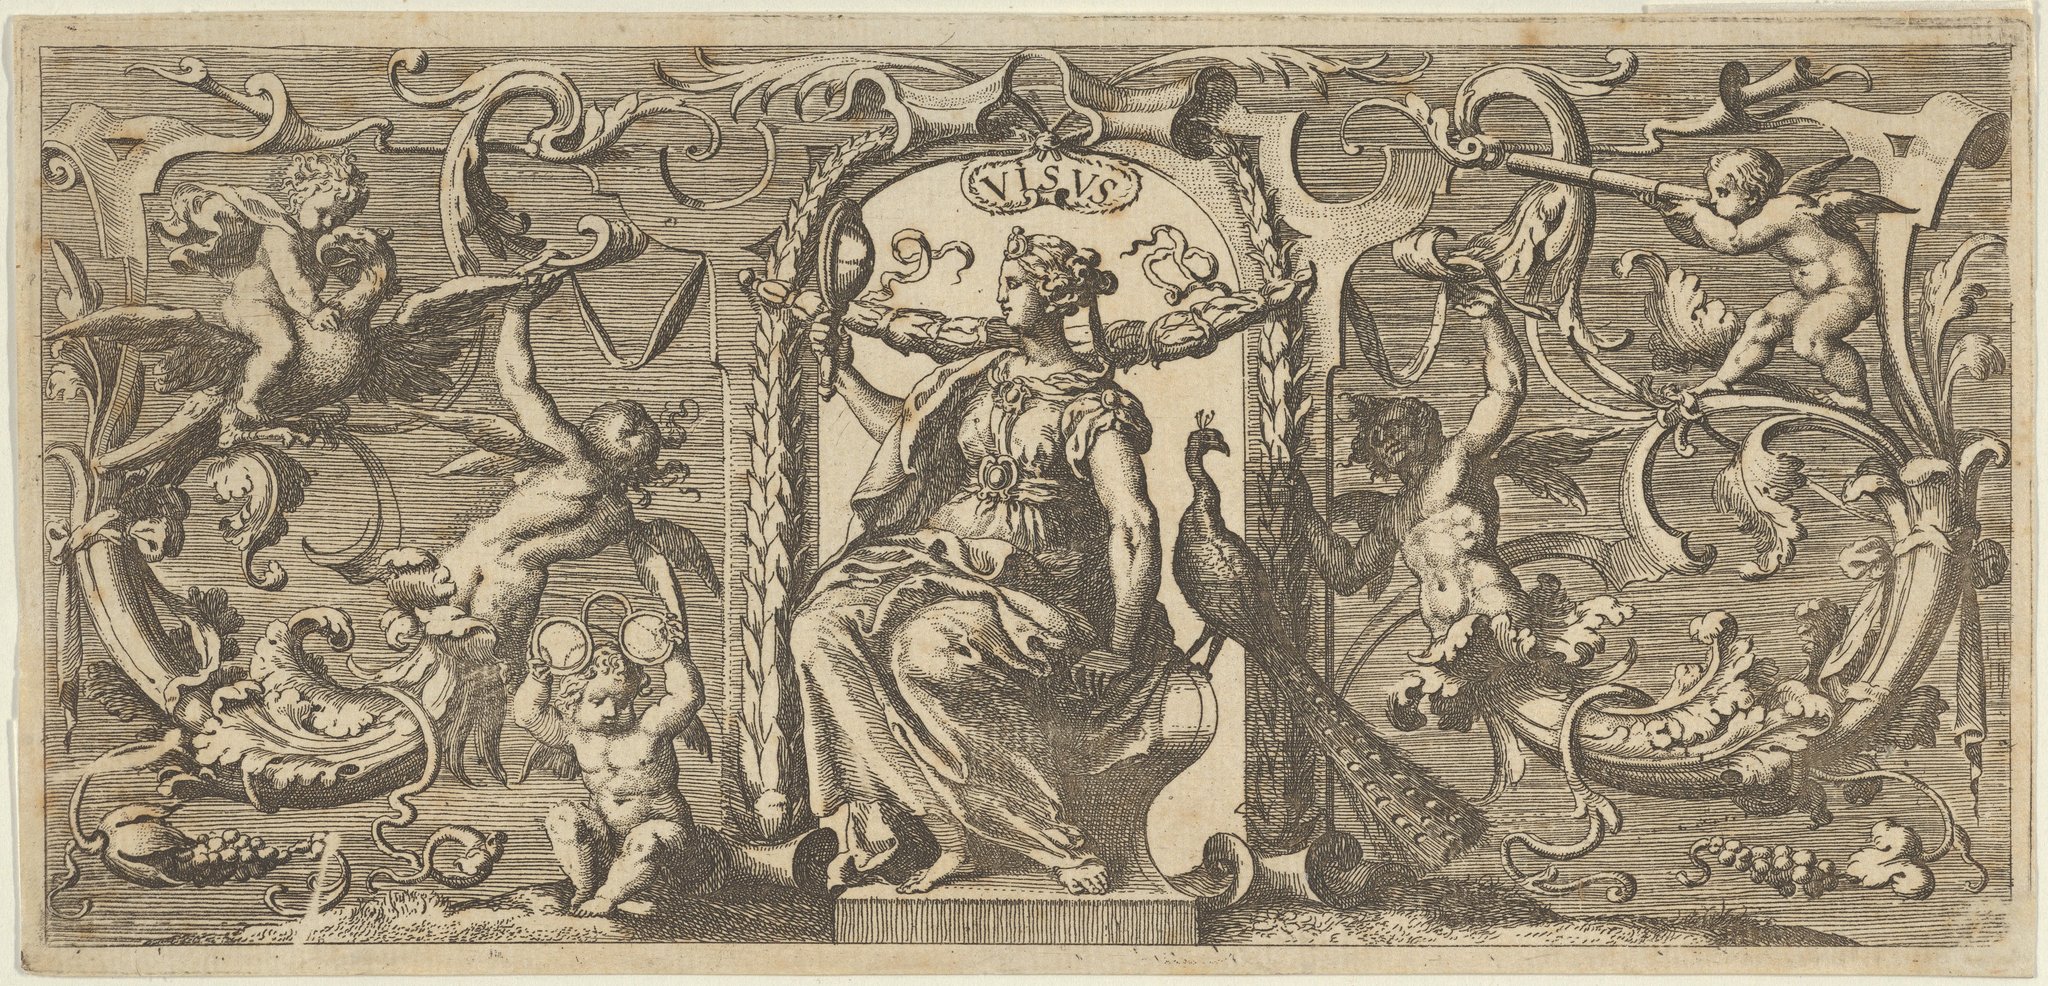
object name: print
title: Sight (Visus), from "Quinque Sensuum"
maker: franz cleyn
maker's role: artist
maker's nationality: german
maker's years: 1582-1658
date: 1655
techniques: engraving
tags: eagles,women,mythical creatures,peacocks,mirrors